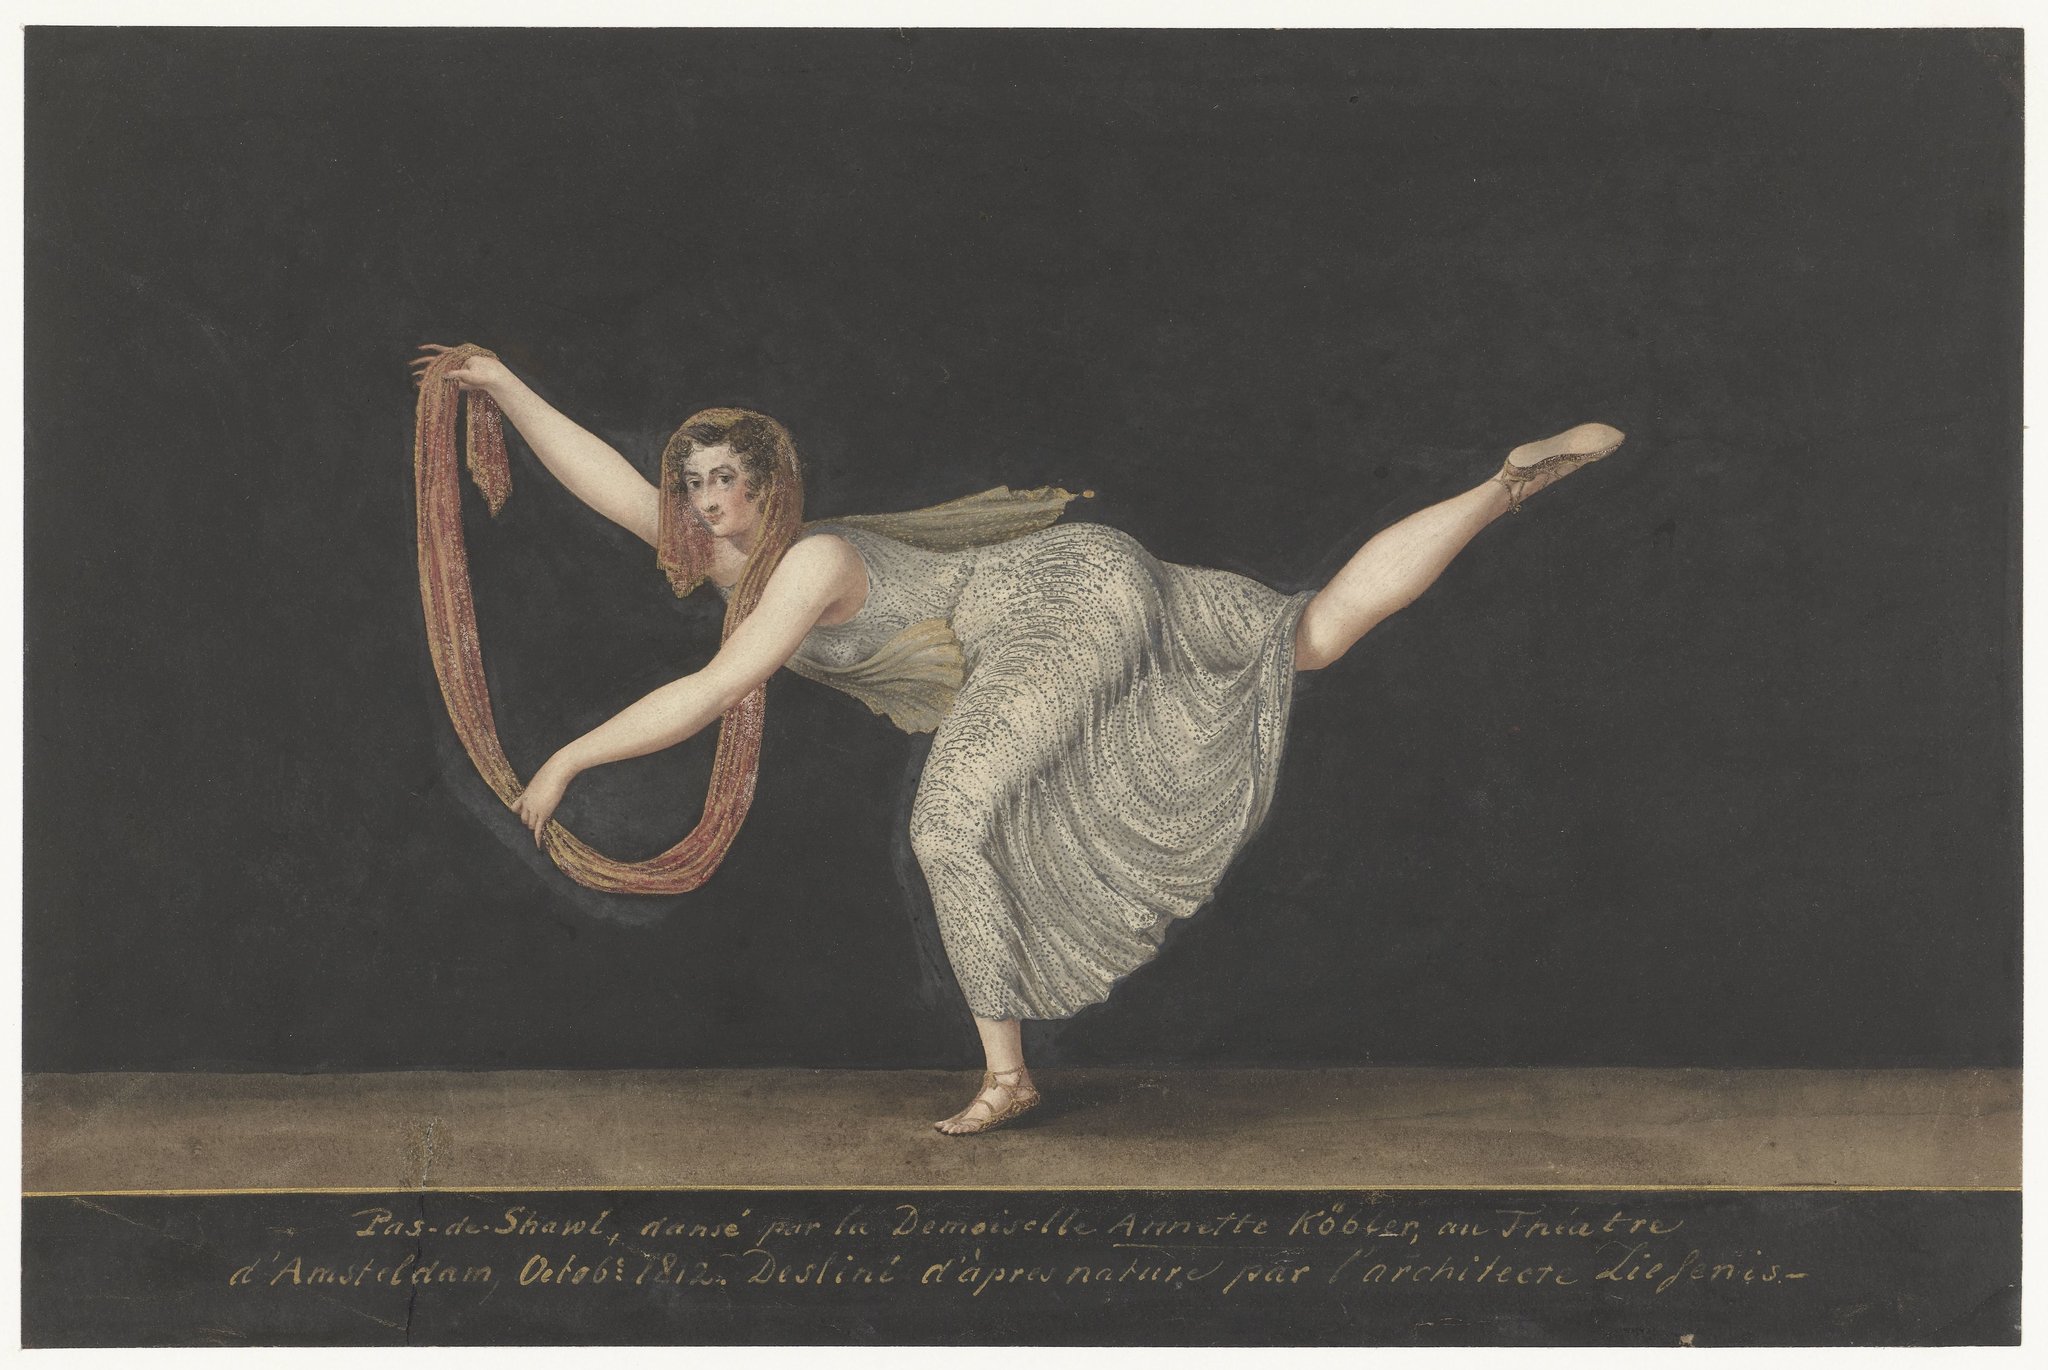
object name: watercolor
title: Danseres Annette Köbler, de pas-de-shawl uitvoerende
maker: bartholomeus ziesenis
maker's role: draughtsman, sculptor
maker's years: 1768-1820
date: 1810-1812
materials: paint, ink, paper, watercolor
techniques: brush, pen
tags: vienna, woman dancing alone, historical persons, female dancer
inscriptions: : ‘Pas-de-Shawl, dansé par la Demoiselle Annette Köbler au Théatre d'Amsteldam Octob- 1812. Dessiné d'après nature par l'architecte Ziesenis’